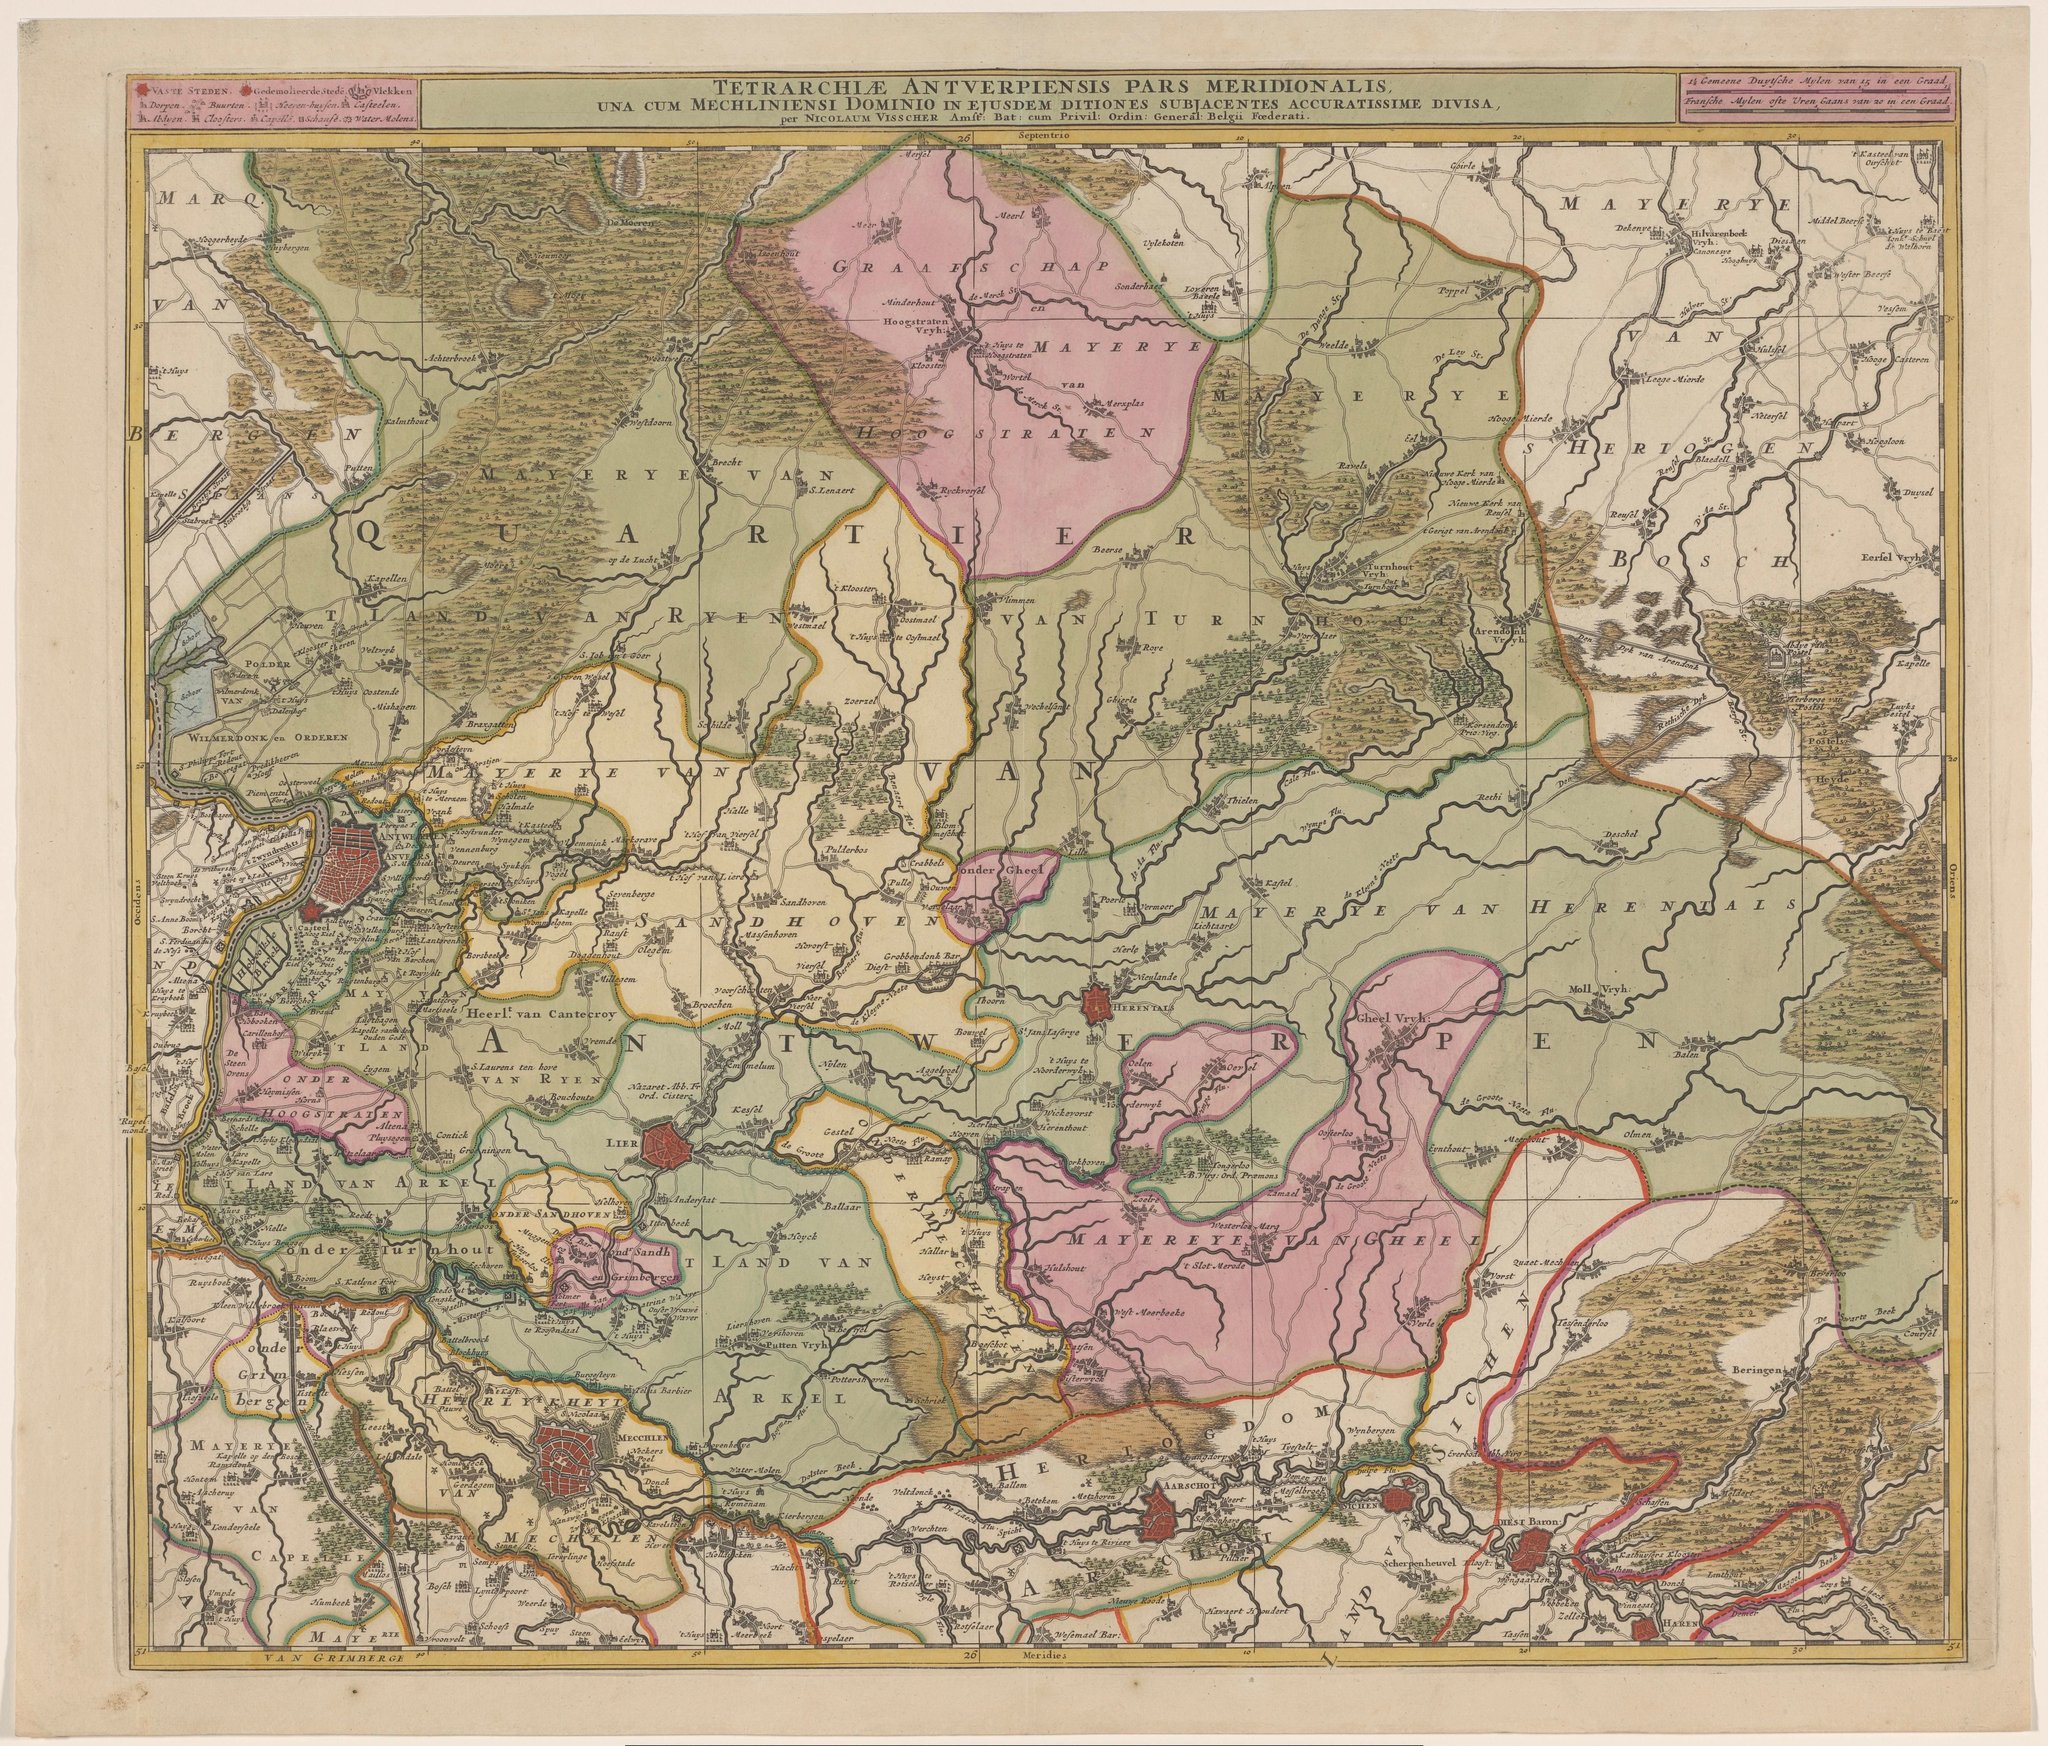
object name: print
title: Kaart van het kwartier van Antwerpen, onderdeel van het hertogdom Brabant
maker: Anonymous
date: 1677-1720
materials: paper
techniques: engraving, etching, hand coloring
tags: maps of separate countries or regions, brabant, antwerp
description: Kaart van het kwartier van Antwerpen, één van de vier kwartieren waarin het hertogdom Brabant is verdeeld. In een balk boven de kaart, in het midden, de titel. Links hiervan een legenda. Rechts van de titel twee schaalstokken: 1 1/2 Gemeene Duytsche Mijlen van 15 in een Graad / 2 Fransche Mylen ofte Uren Gaans van 20 in een Graad. De kaart is voorzien van een coördinaten-net en een gradenverdeling.